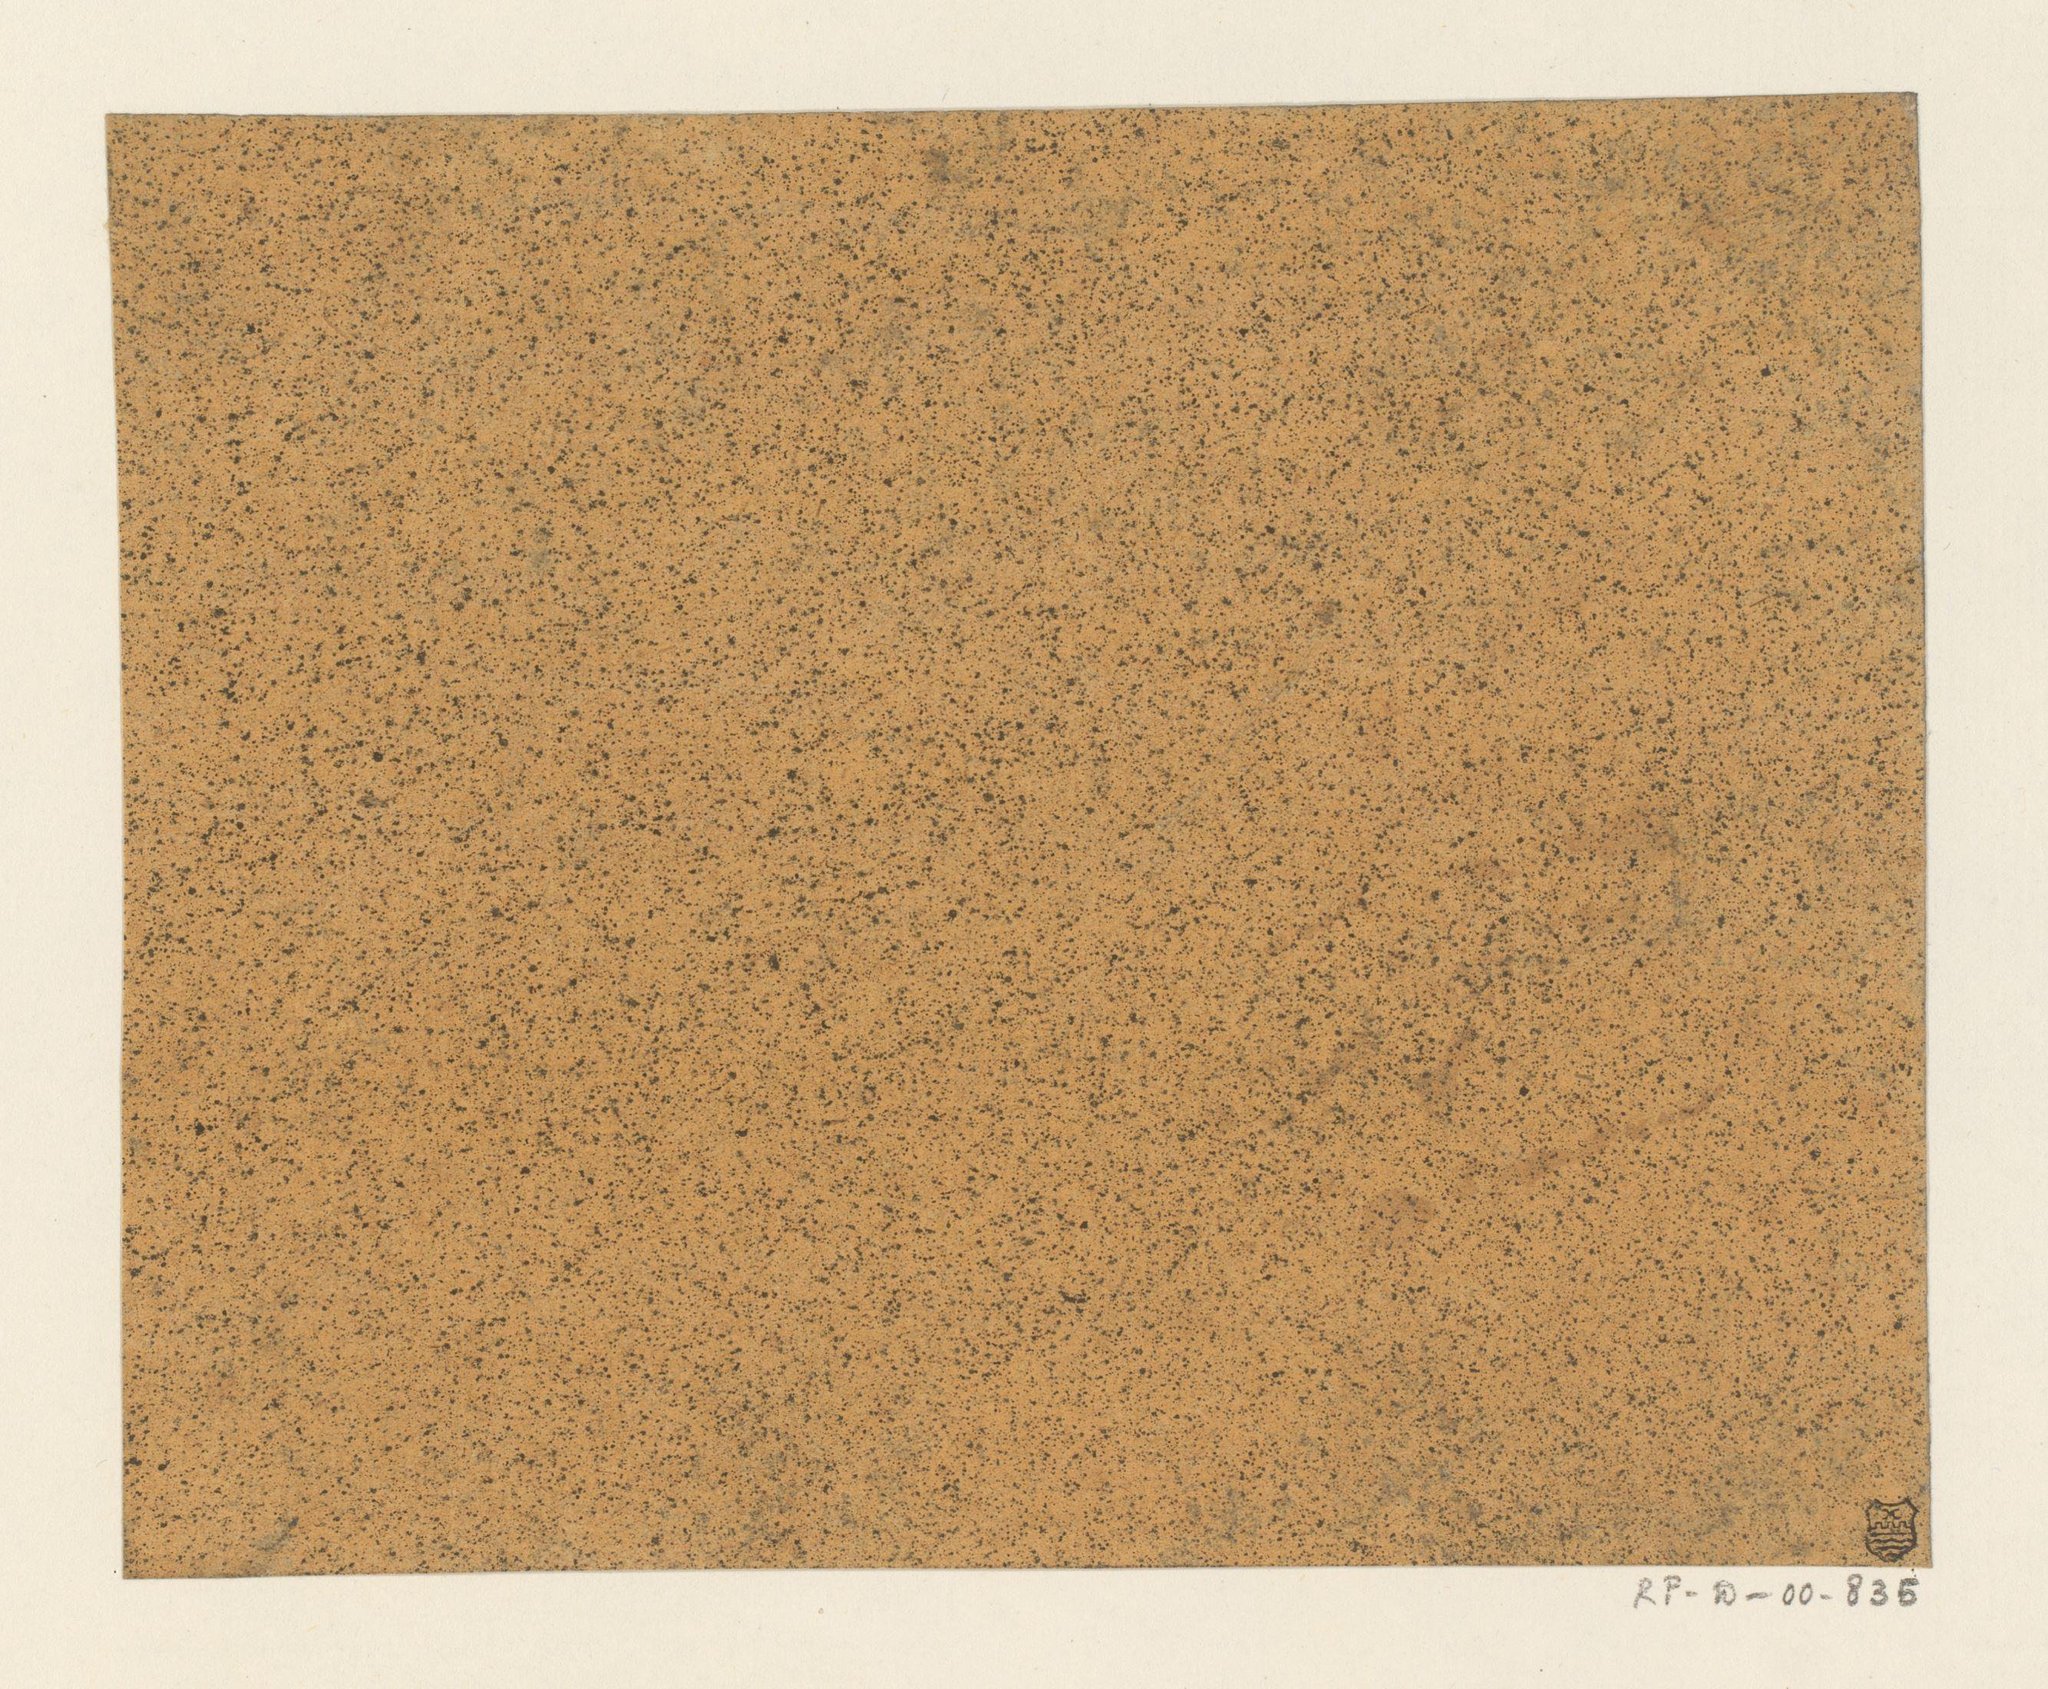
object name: sprinkled paper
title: Zwart gespikkeld geelbruin papier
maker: Anonymous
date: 1750-1900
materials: paper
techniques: kievitsmarmer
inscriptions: collector's mark: Lugt 2760